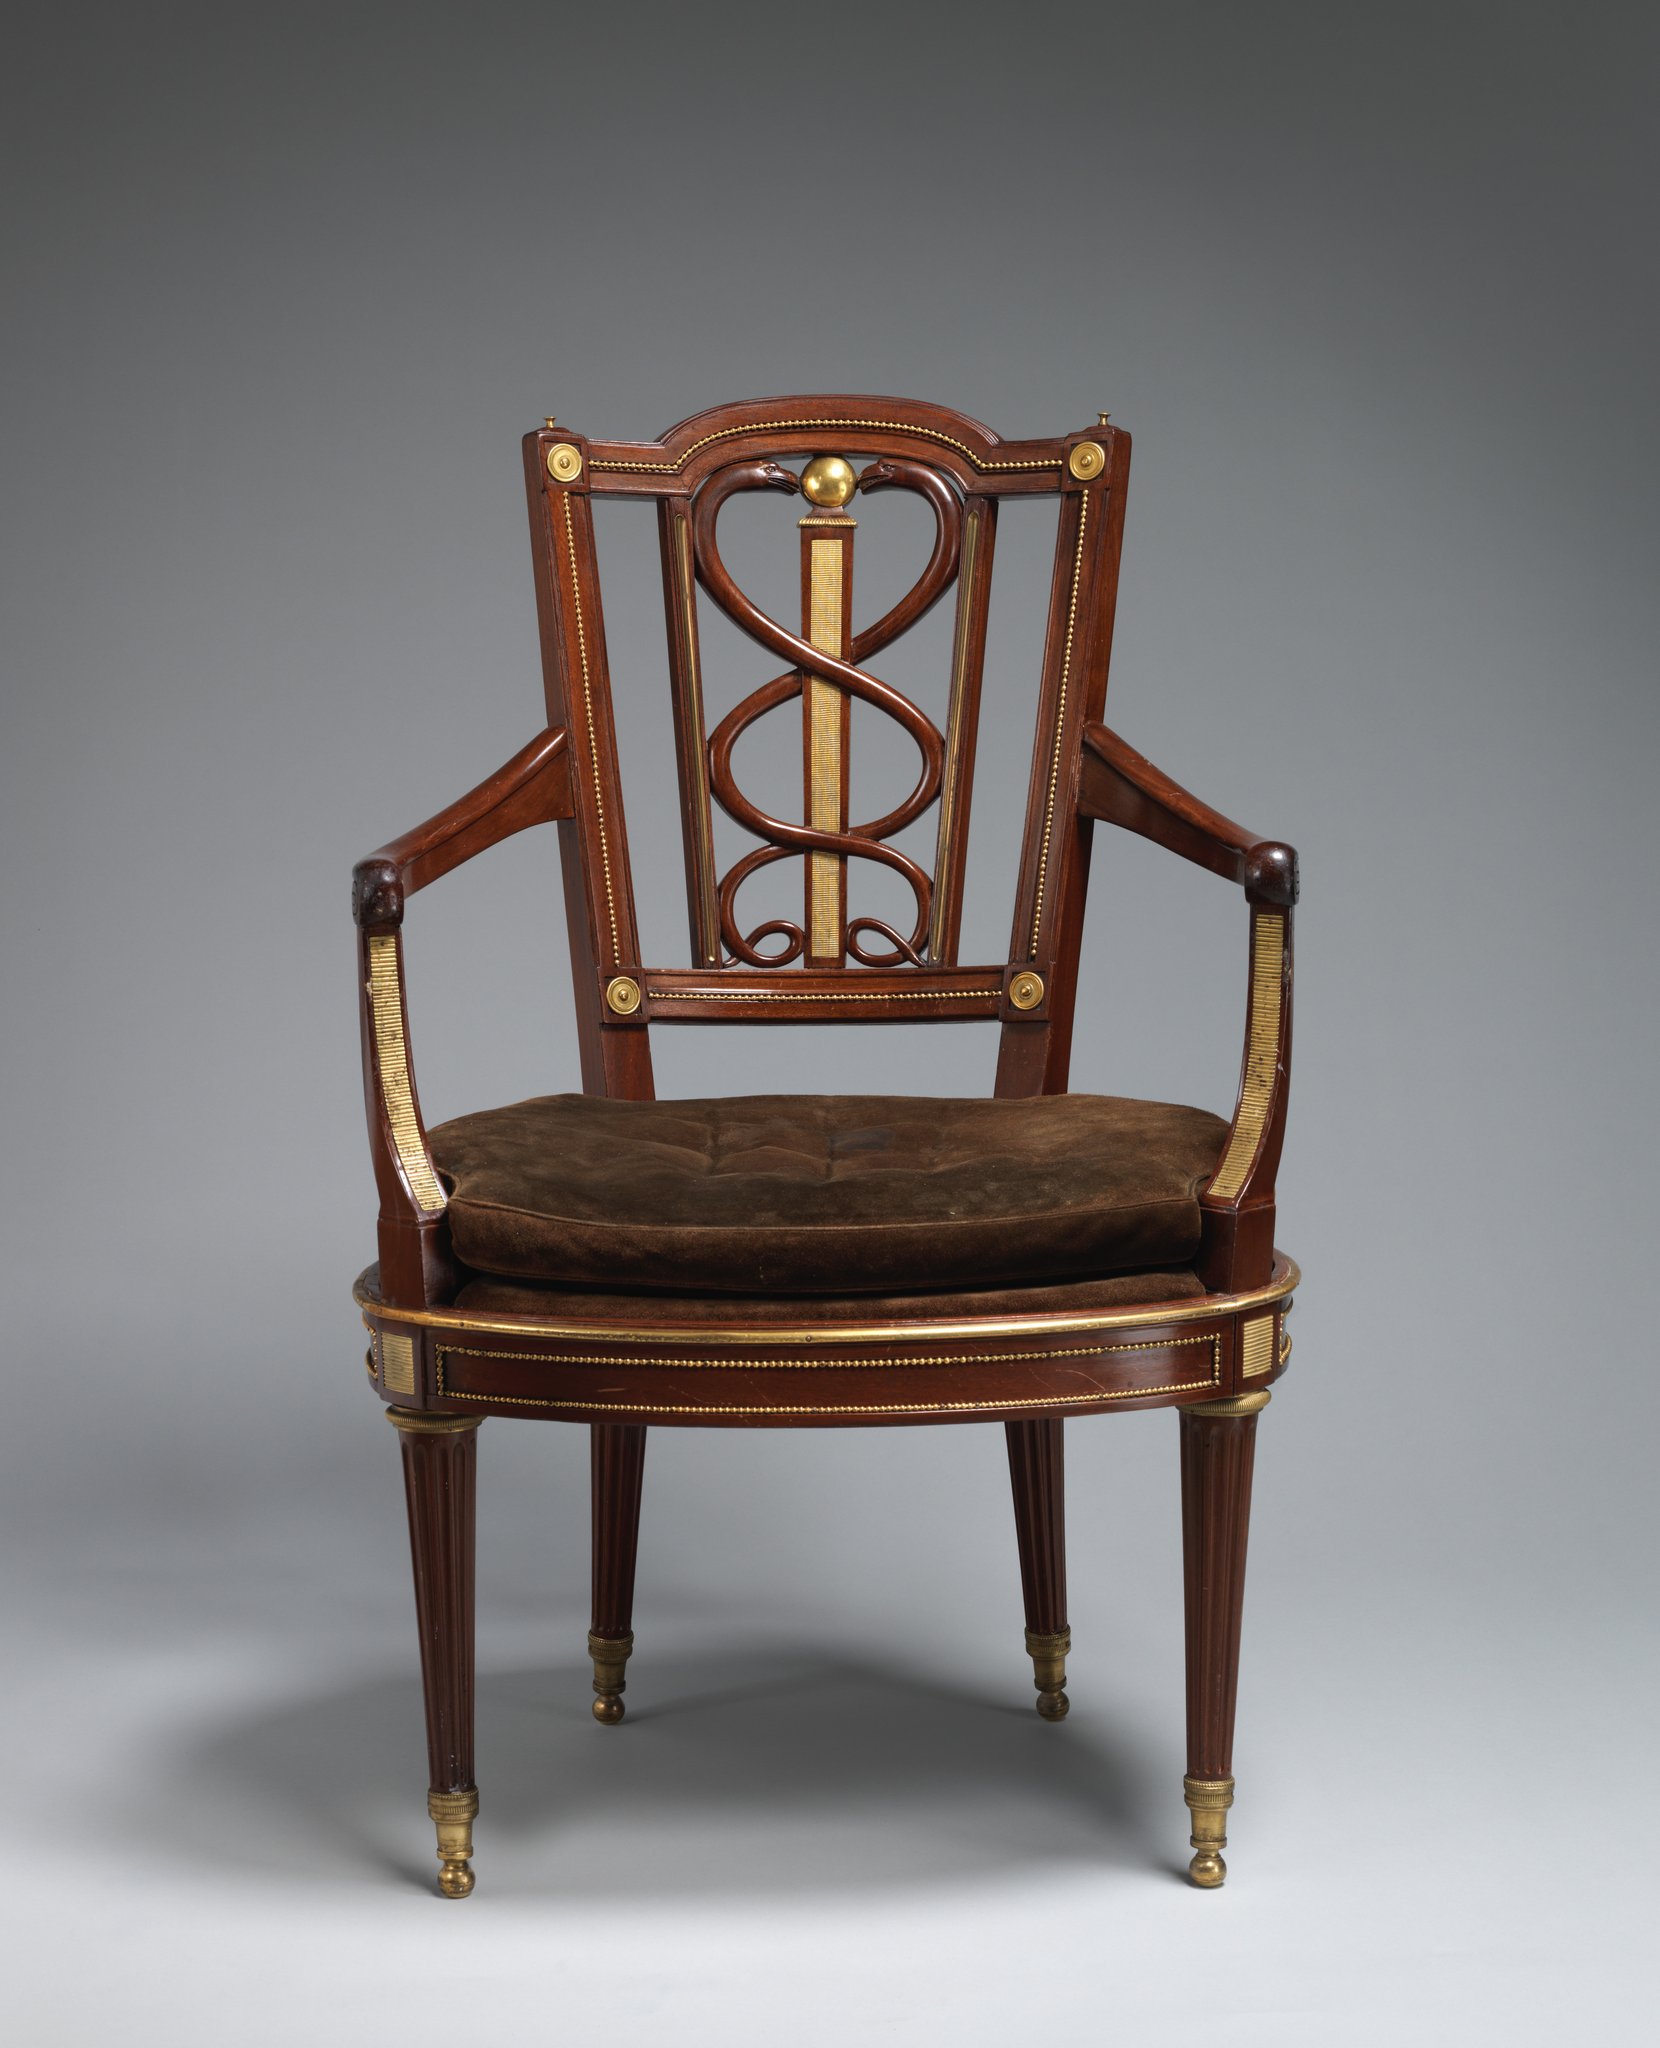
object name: armchair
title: Armchair en cabriolet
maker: david roentgen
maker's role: maker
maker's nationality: german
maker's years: 1743-1807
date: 1785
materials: brass, gilt bronze, wood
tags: snakes